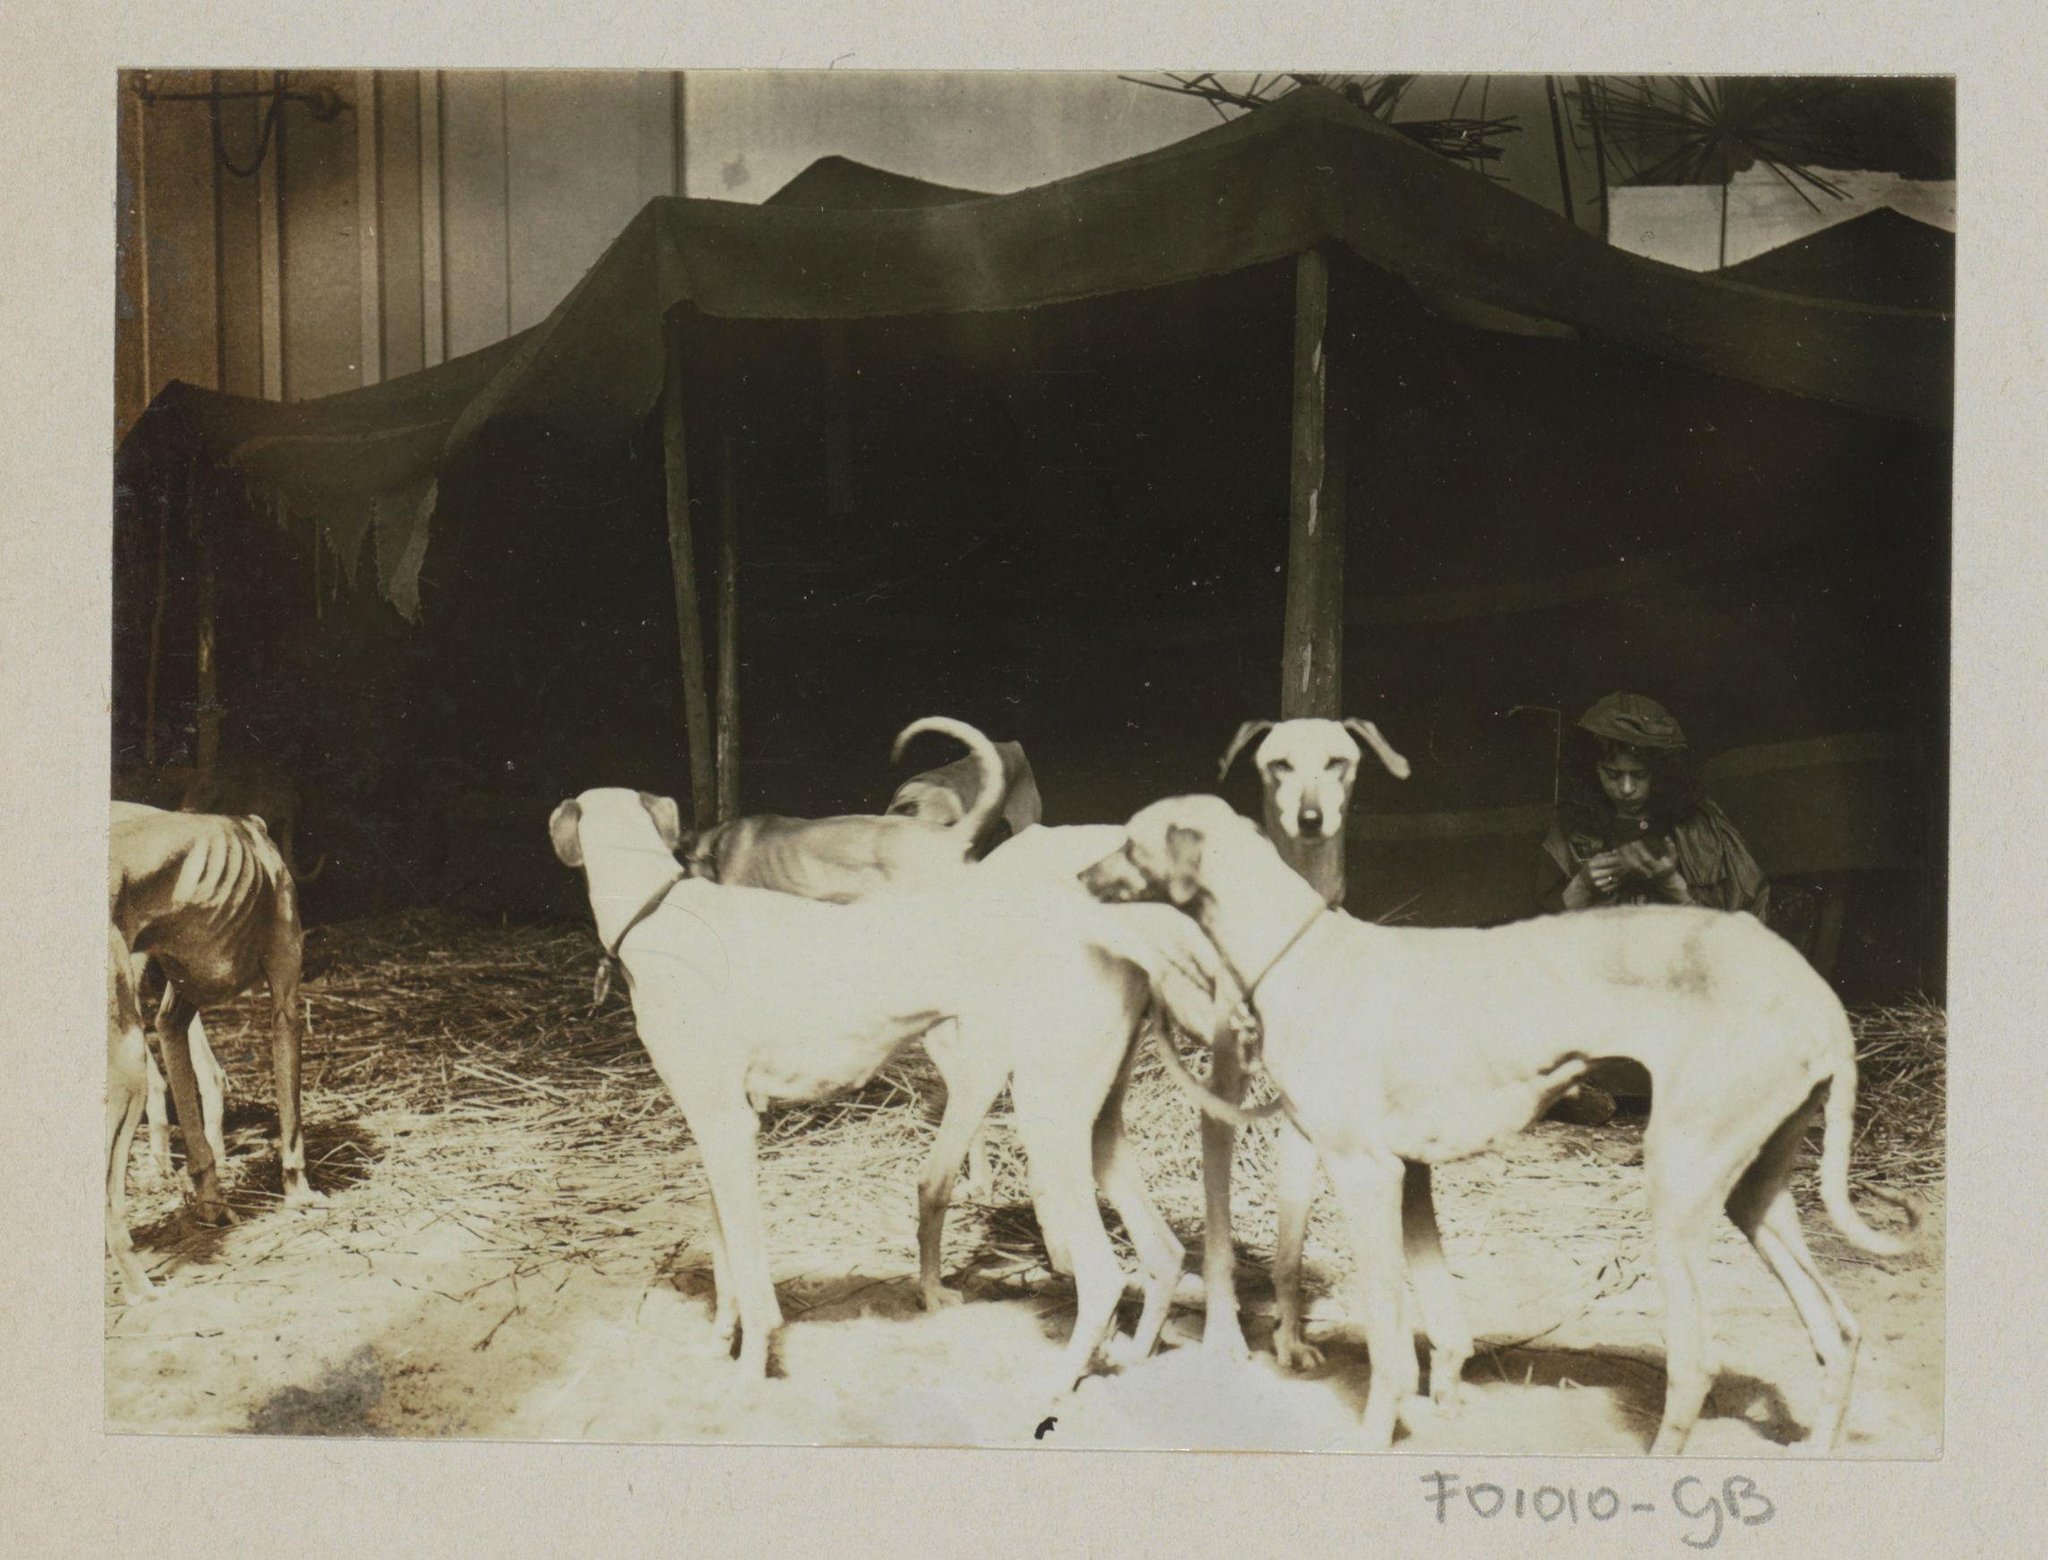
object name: photograph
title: Hazewindhonden bij een tent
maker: Anonymous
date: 1900-1910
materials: photographic support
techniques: gelatin silver print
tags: tent, dog (with name of kind)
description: Onderdeel van Familiealbum met onder meer foto's van Wijnhandel Kraaij & Co. Bordeaux-Amsterdam.